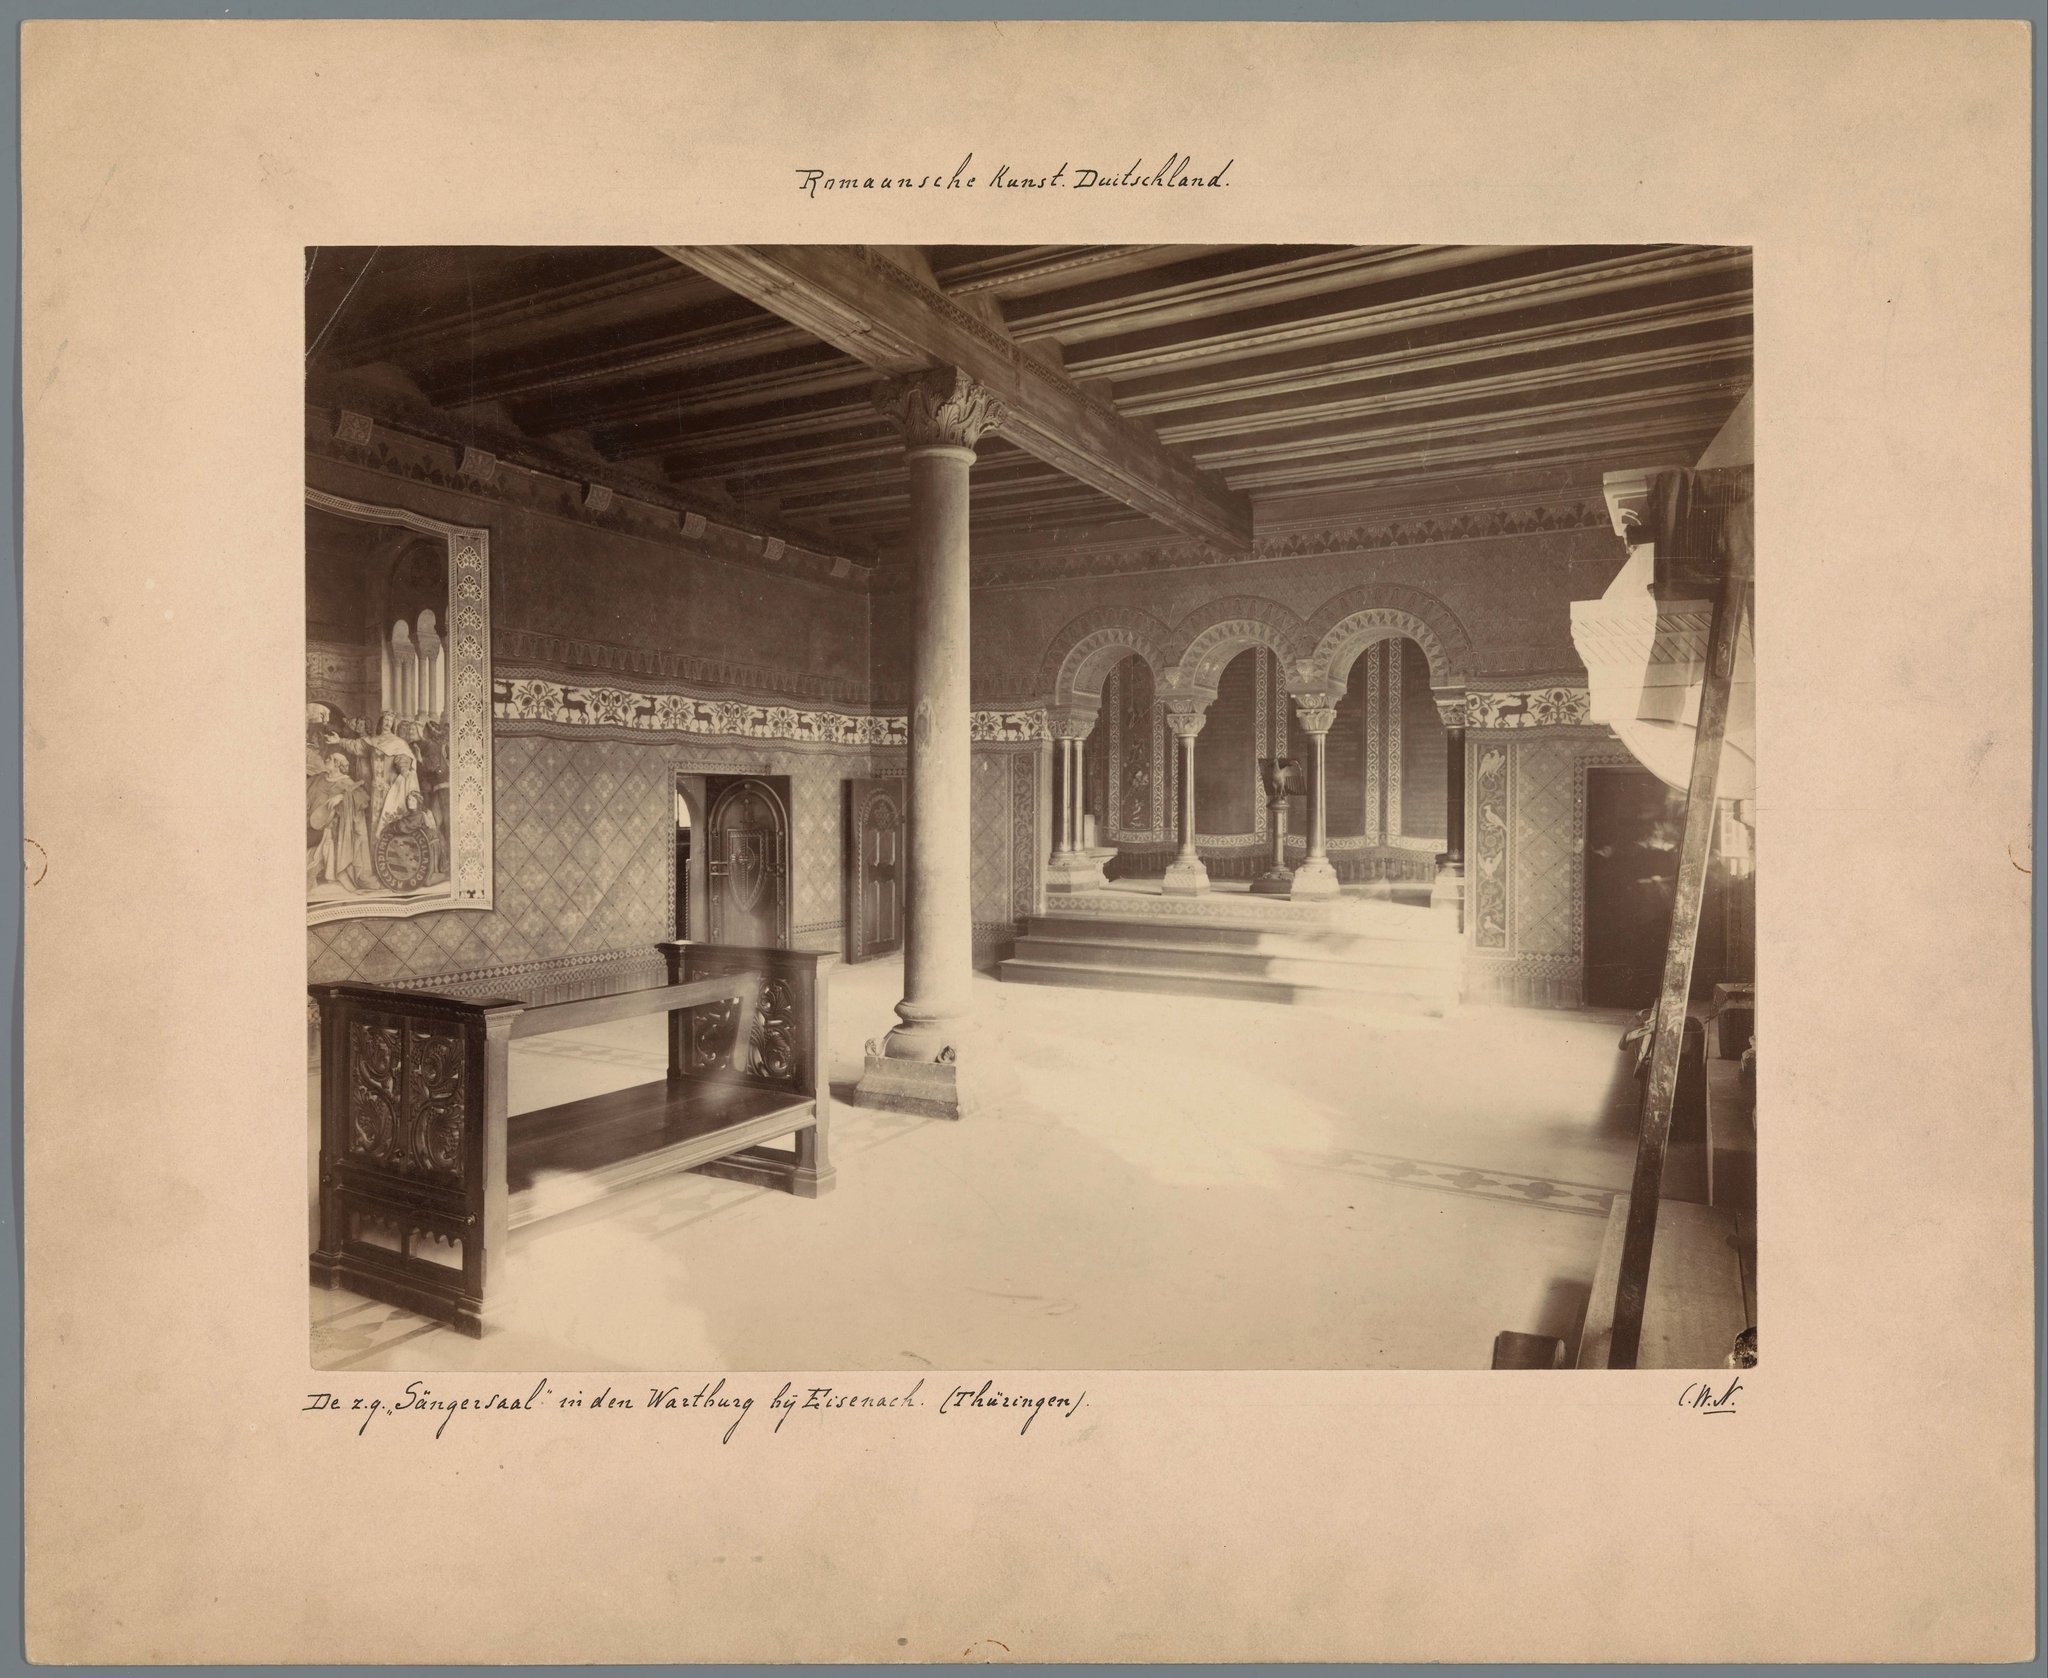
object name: photograph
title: Interieur van de Sängersaal in de Wartburg te Eisenach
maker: Anonymous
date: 1808-1896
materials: cardboard, photographic support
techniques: albumen print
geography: wartburg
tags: bench, column, pillar ~ architecture, castle, interior ~ representation of a building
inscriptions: collector's mark: ‘KUNSTNIJVERHEIDSCHOOL QUELLINUS AMSTERDAM FRANS HALSSTRAAT 14.’, collector's mark: ‘INSTITUUT VOOR KUNST- NIJVERHEIDSONDERWIJS GABRIËL METSUSTRAAT No. 16. AMSTERDAM’, inscription: ‘Eisenach. Aug 1896. De zogenaamde ,,Sängersaal'' op den Wartburg .’, inscription: ‘Romaansche Kunst - Duitschland . De z.g. ,,Sängersaal'' in den Wartburg bij Eisenach. (Thüringen).’, inscription: ‘C.W.N.’